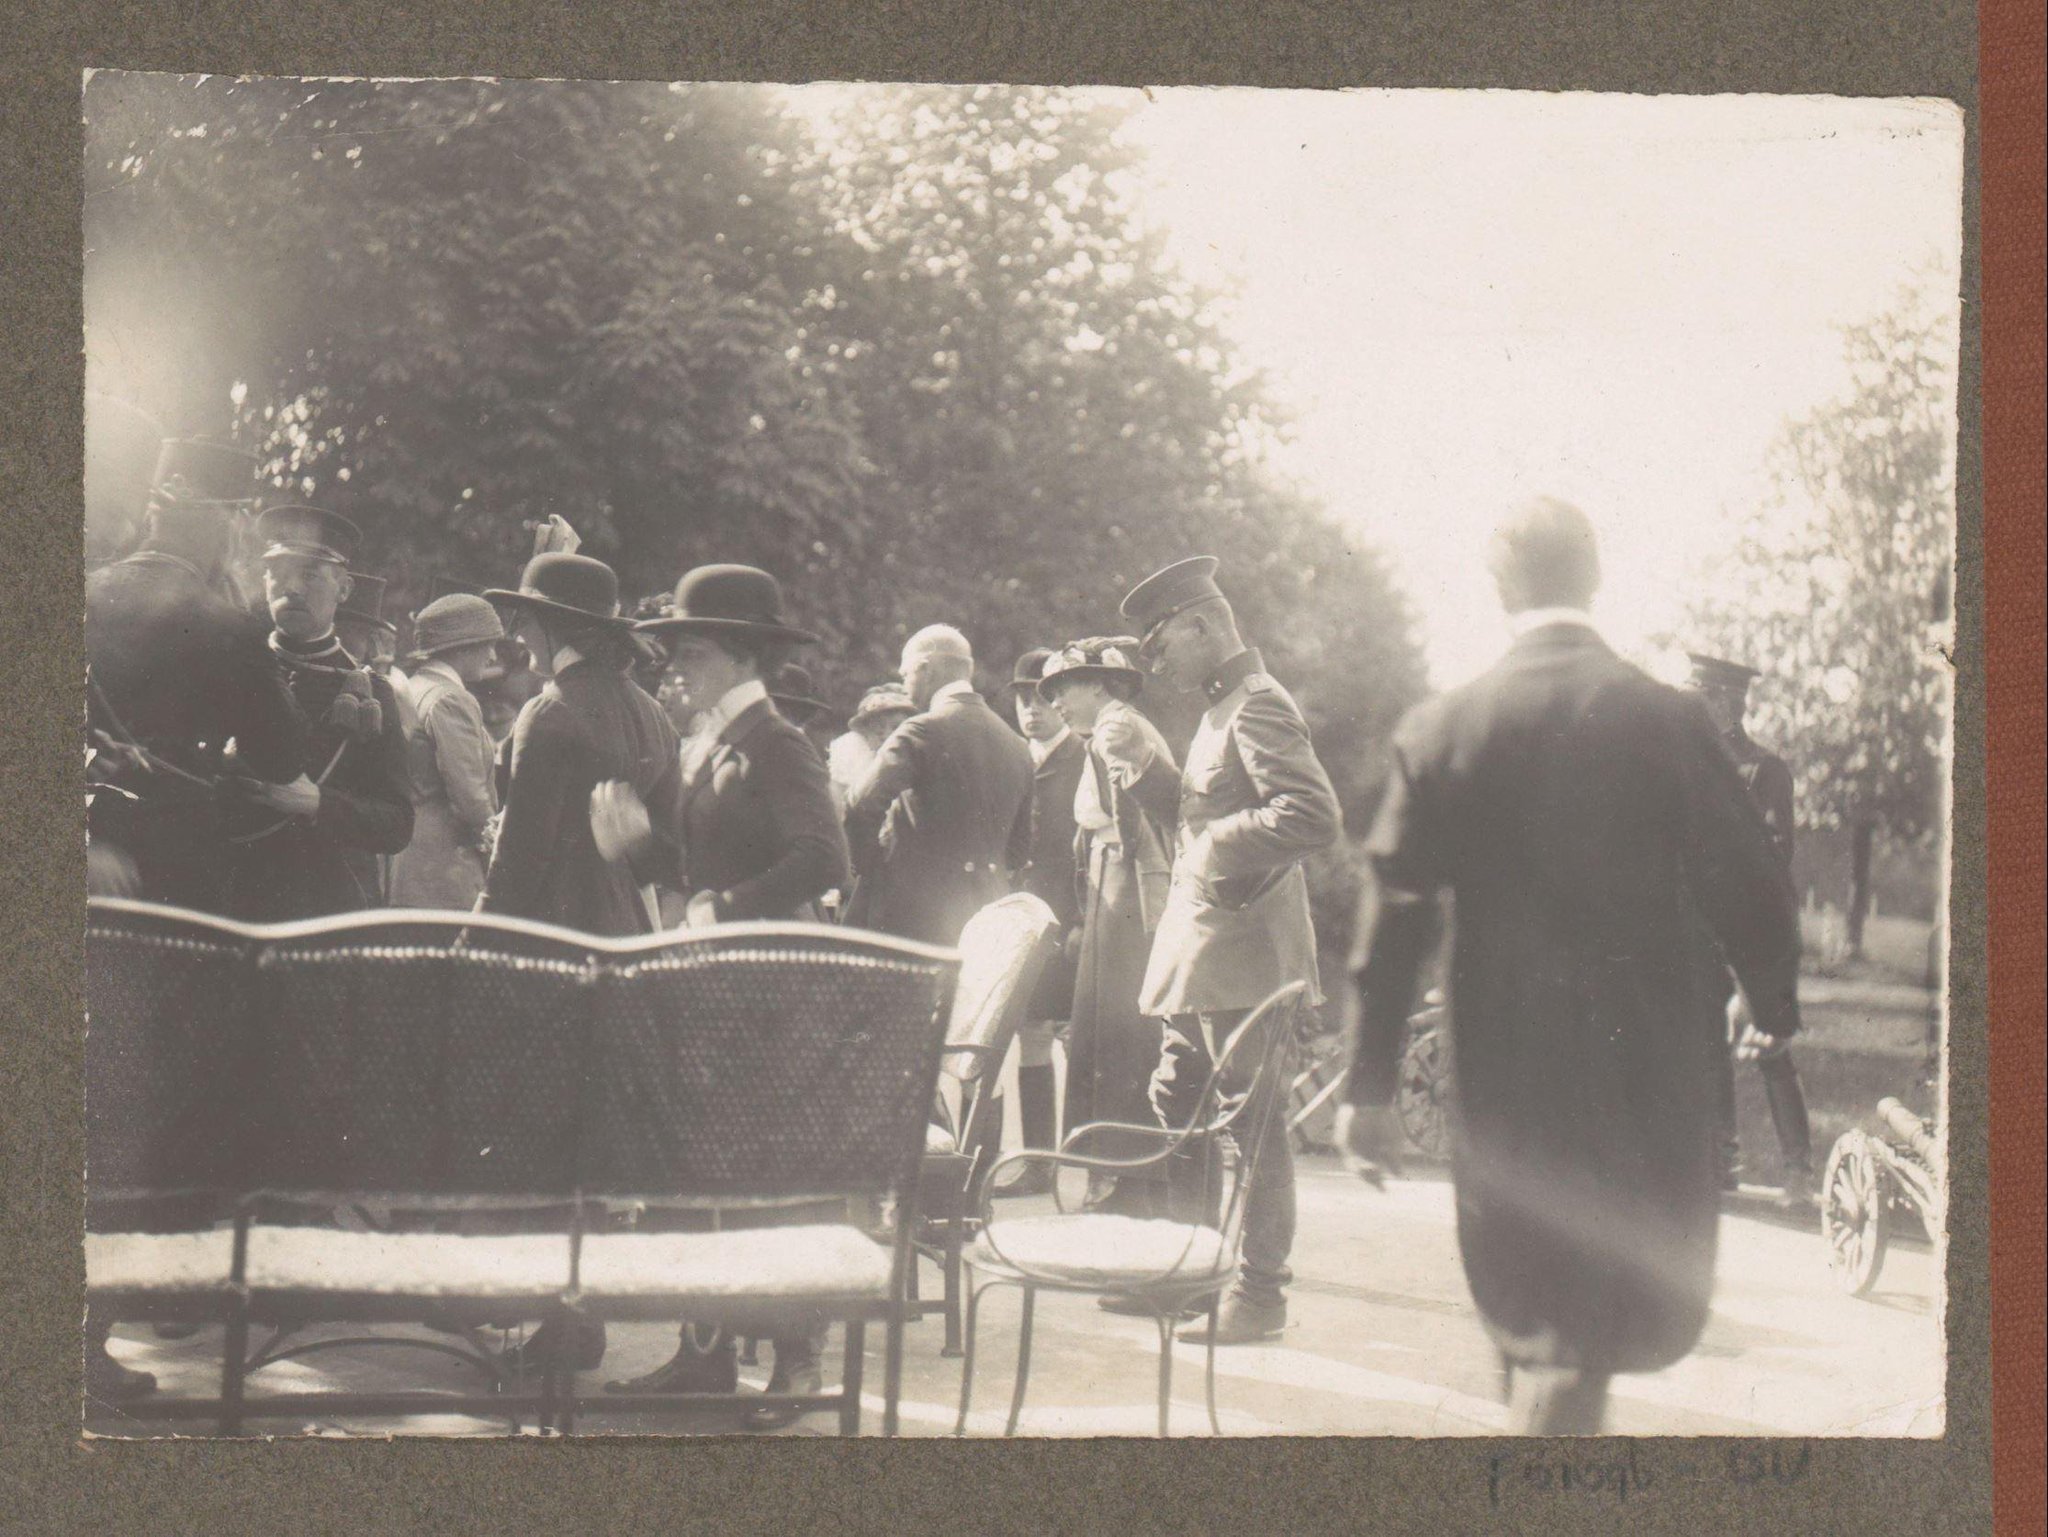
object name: album leaf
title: Ruitertafereel op Koninklijke Houtvesterij Het Loo: gezelschap in een tuin met rechts een kanon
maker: Anonymous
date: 1900-1925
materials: photographic support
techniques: gelatin silver print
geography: het loo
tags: hunting, chase, hunting-ground, firearms: cannon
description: Onderdeel van Fotoalbum van de heer Brams, opperhoutvester van koningin Wilhelmina op Koninklijke Houtvesterij Het Loo.